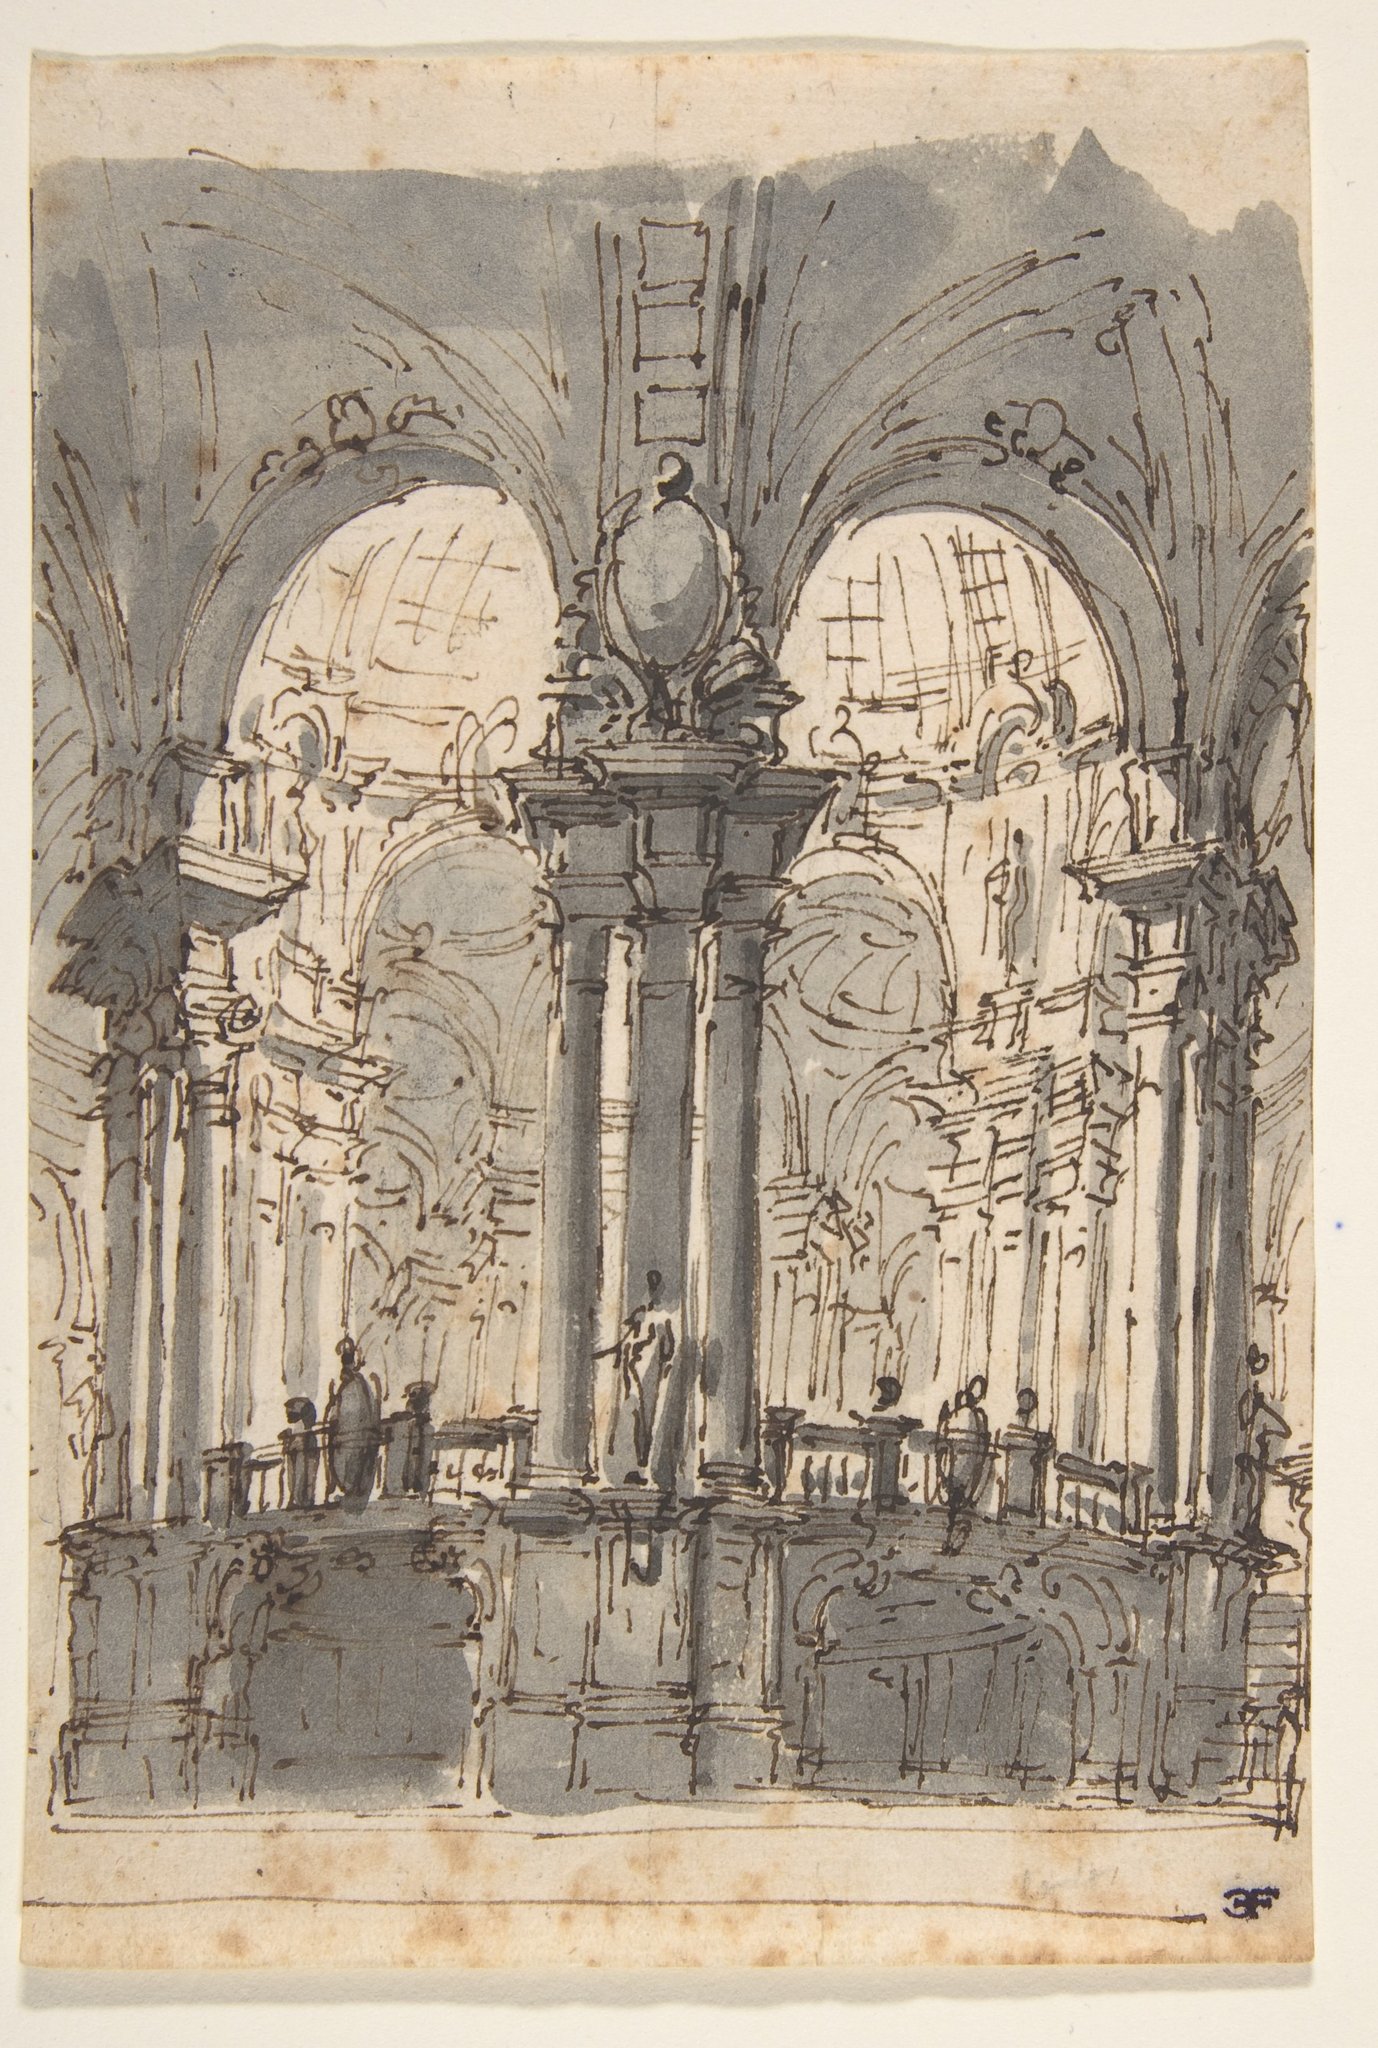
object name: drawing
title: Design for Stage Set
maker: giovanni battista natali iii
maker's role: artist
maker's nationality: italian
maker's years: 1698-1765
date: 1698-1765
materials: ink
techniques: brush, pen, wash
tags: stage design